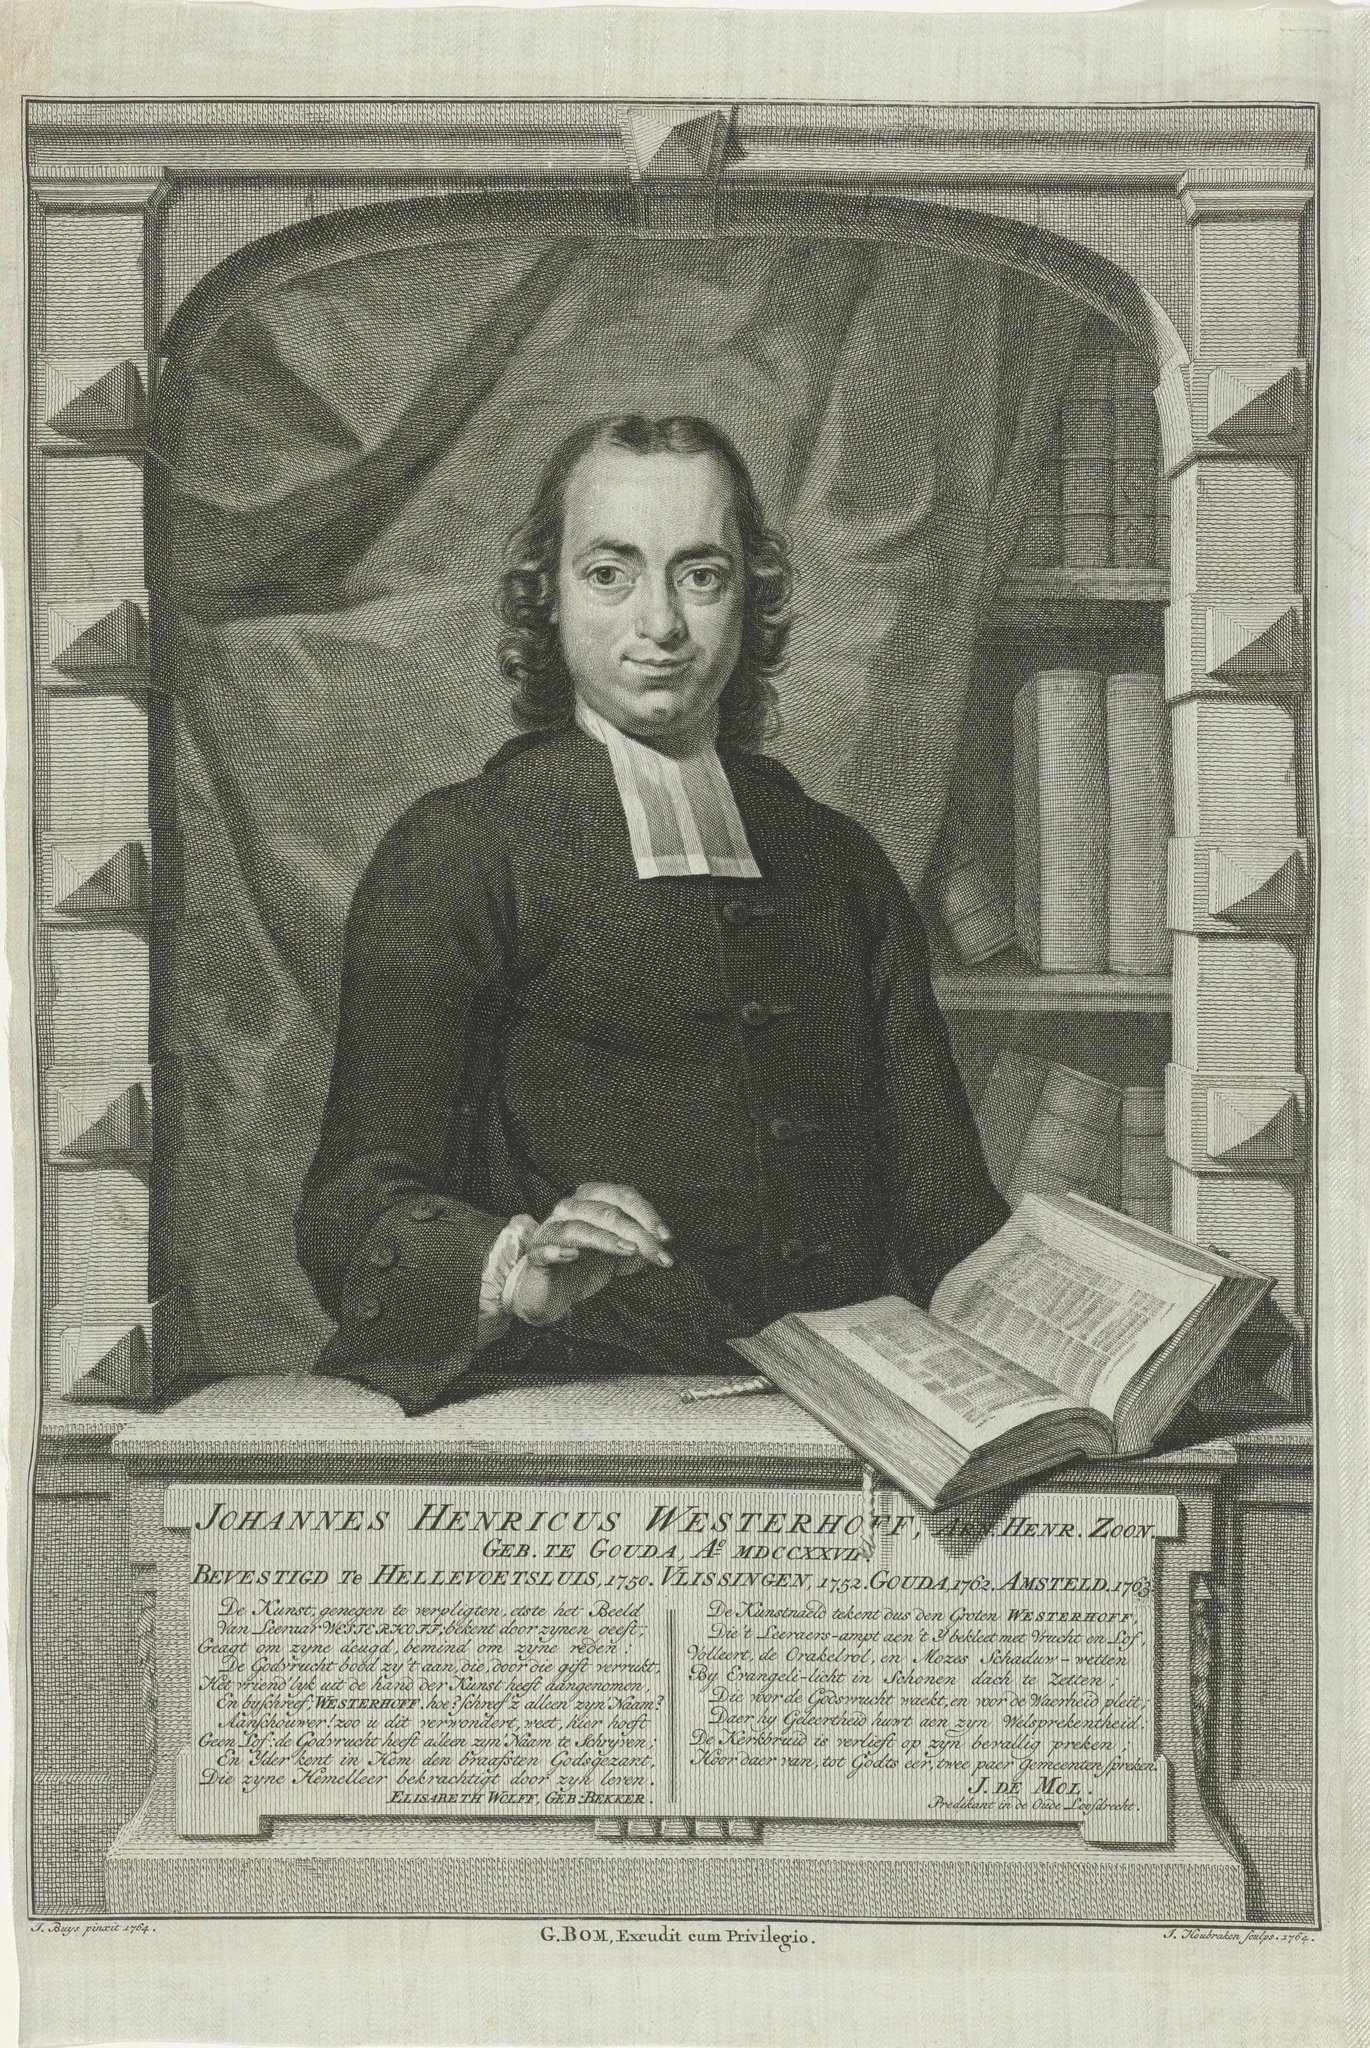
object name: print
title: Portret van Johannes Henricus Westerhoff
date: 1764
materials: silk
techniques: engraving, etching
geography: amsterdam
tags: gouda, the bible as a book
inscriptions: collector's mark: Lugt 2228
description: Portret ten halven lijve van Johannes Henricus Westerhoff, in een architectonische venstervormige omlijsting, met voor hem een opengeslagen bijbel. Onder de vensterbank een plaquette met daarop de naam en gegevens van de geportretteerde in drie regels in het Nederlands en daaronder twee naast elkaar geplaatste verzen: links een tienregelig vers in het Nederlands en rechts een achtregelig vers in het Nederlands.